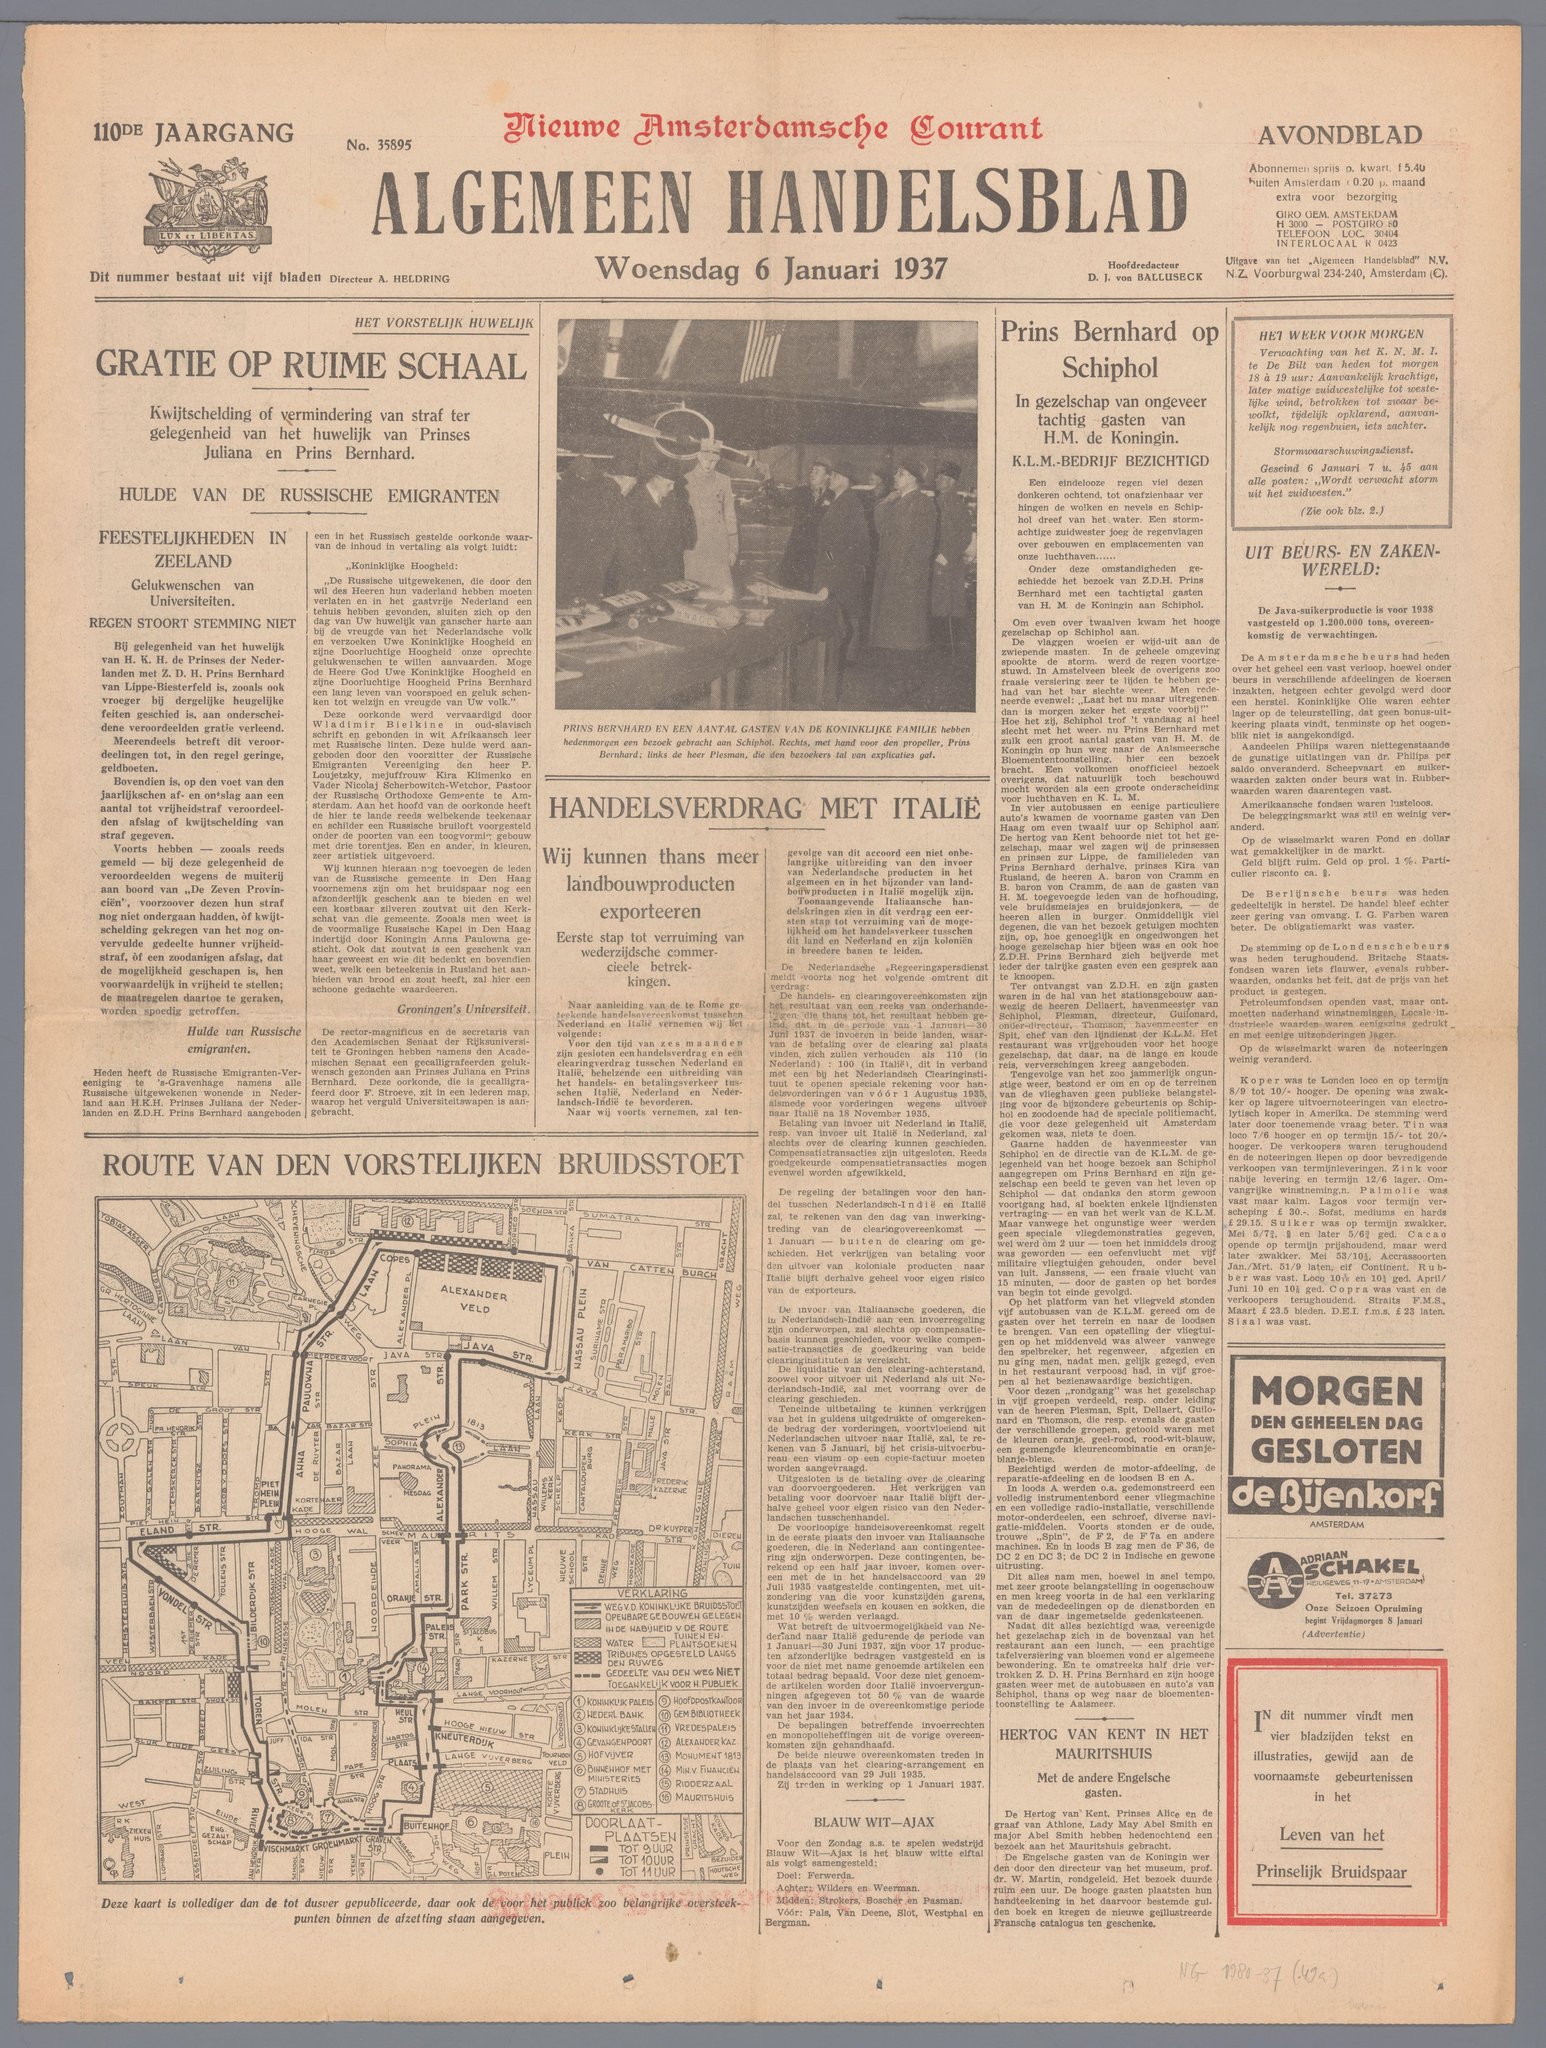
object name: newspaper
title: Algemeen Handelsblad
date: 1937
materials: paper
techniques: printing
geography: amsterdam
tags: utrecht, bernhard (prins der nederlanden), the hague, juliana of the netherlands, netherlands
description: Krant over het huwelijk van Juliana en Bernhard, nr. 35895 van de 110e jaargang van het "Algemeen Handelsblad", 2pp (van de oorspronkelijk 5 bladen).